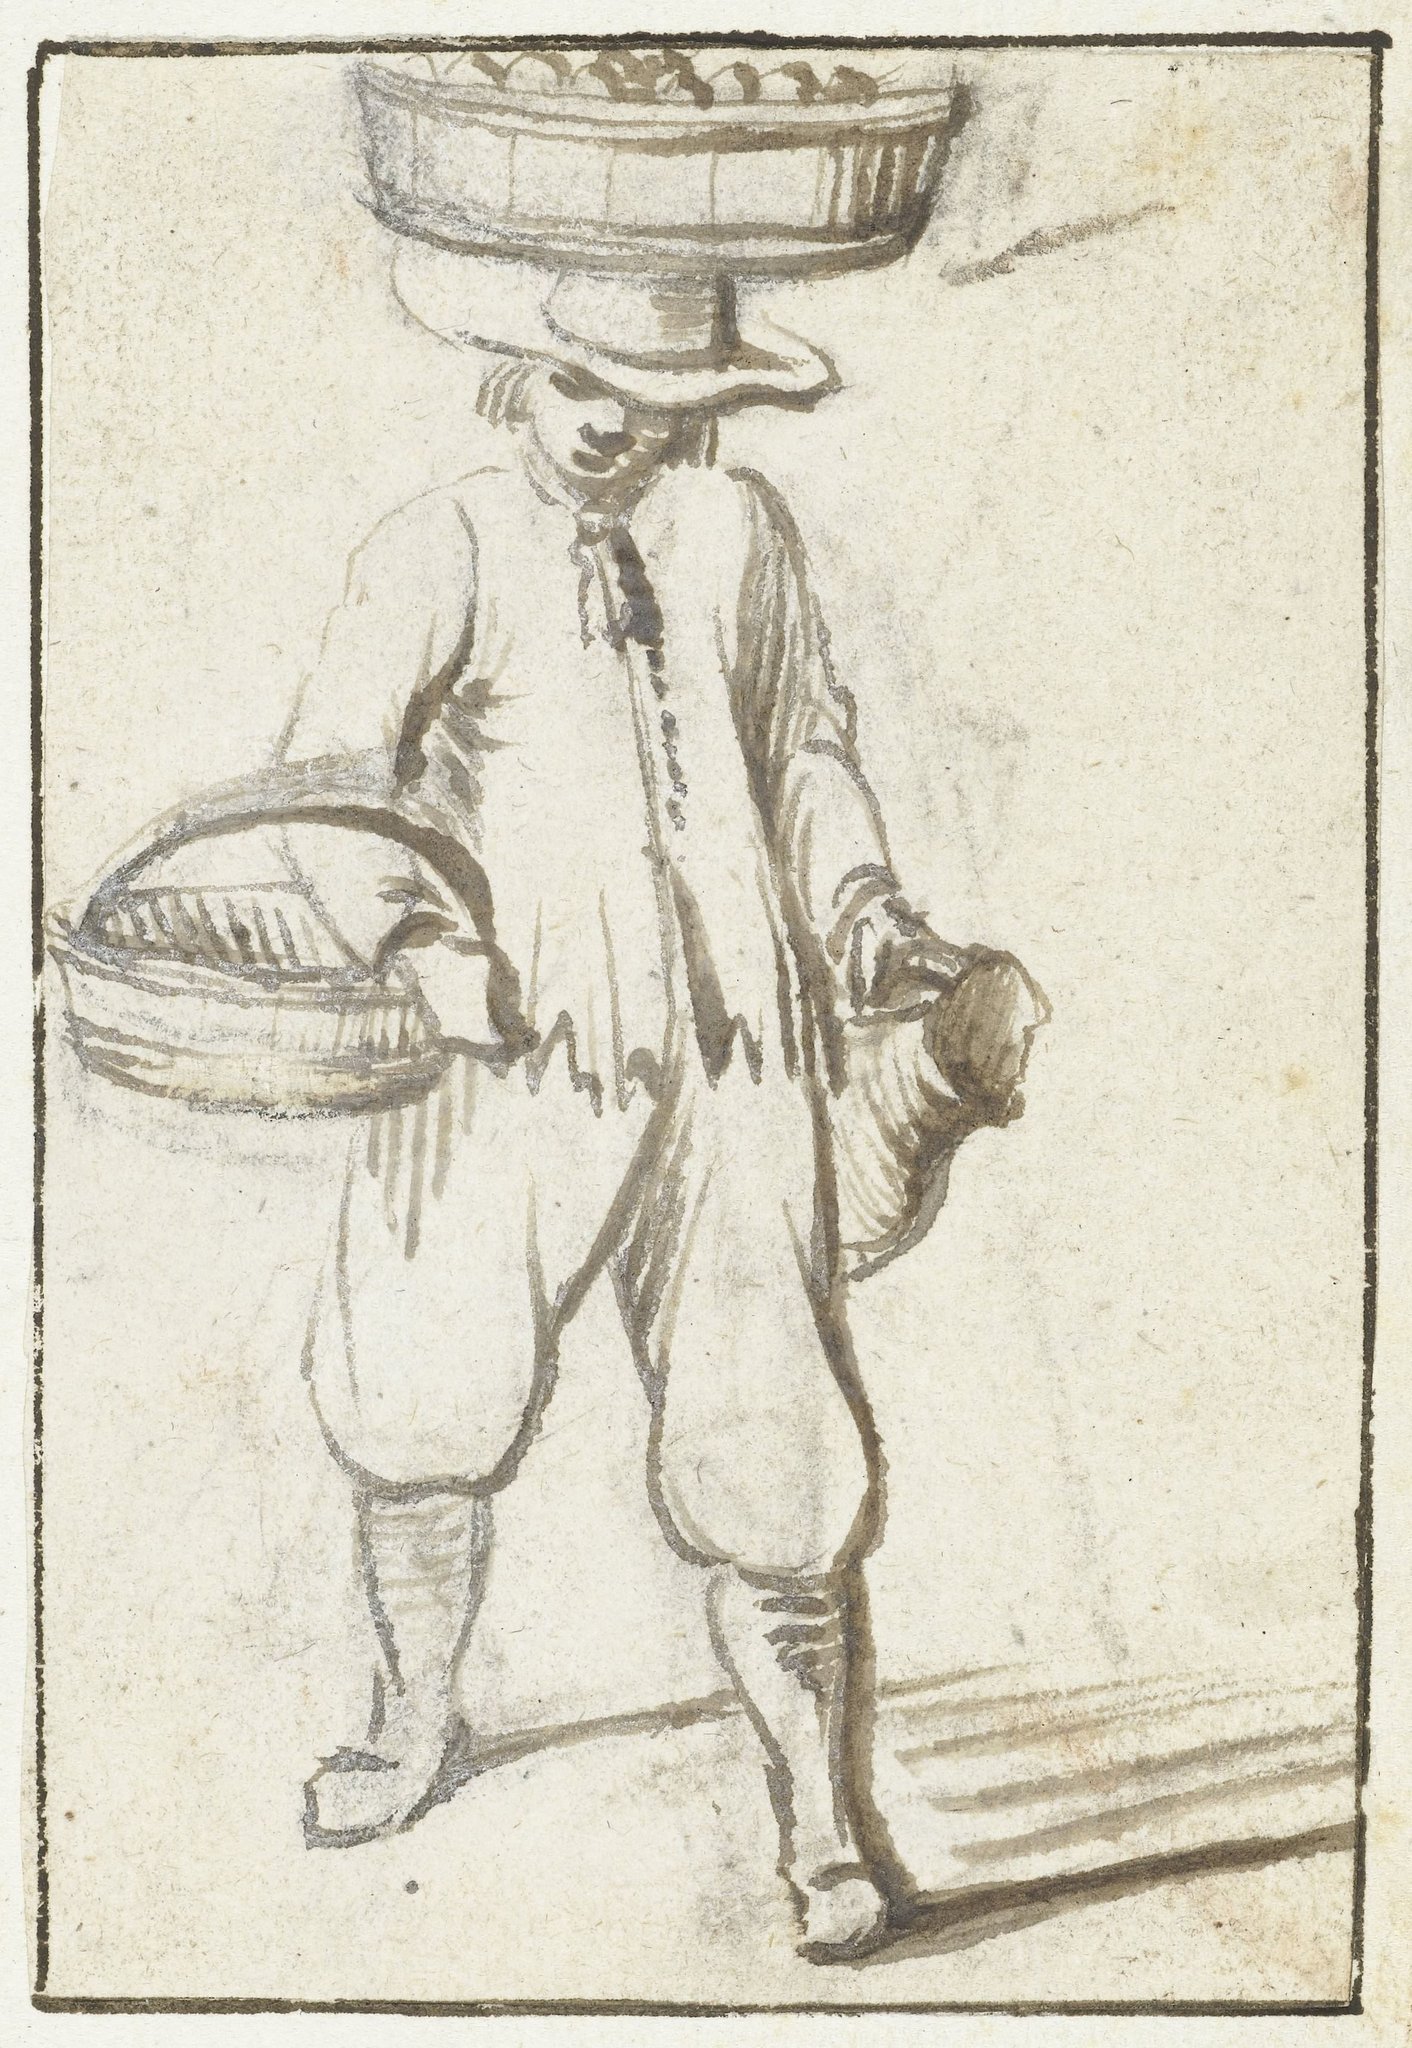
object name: drawing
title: Man met twee manden en een kruik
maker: harmen ter borch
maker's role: draughtsman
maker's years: 1638-1677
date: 1648-1677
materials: chalk, ink, paper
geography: zwolle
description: Tekening naast twee andere tekeningen in het Familie-plakboek geplakt.